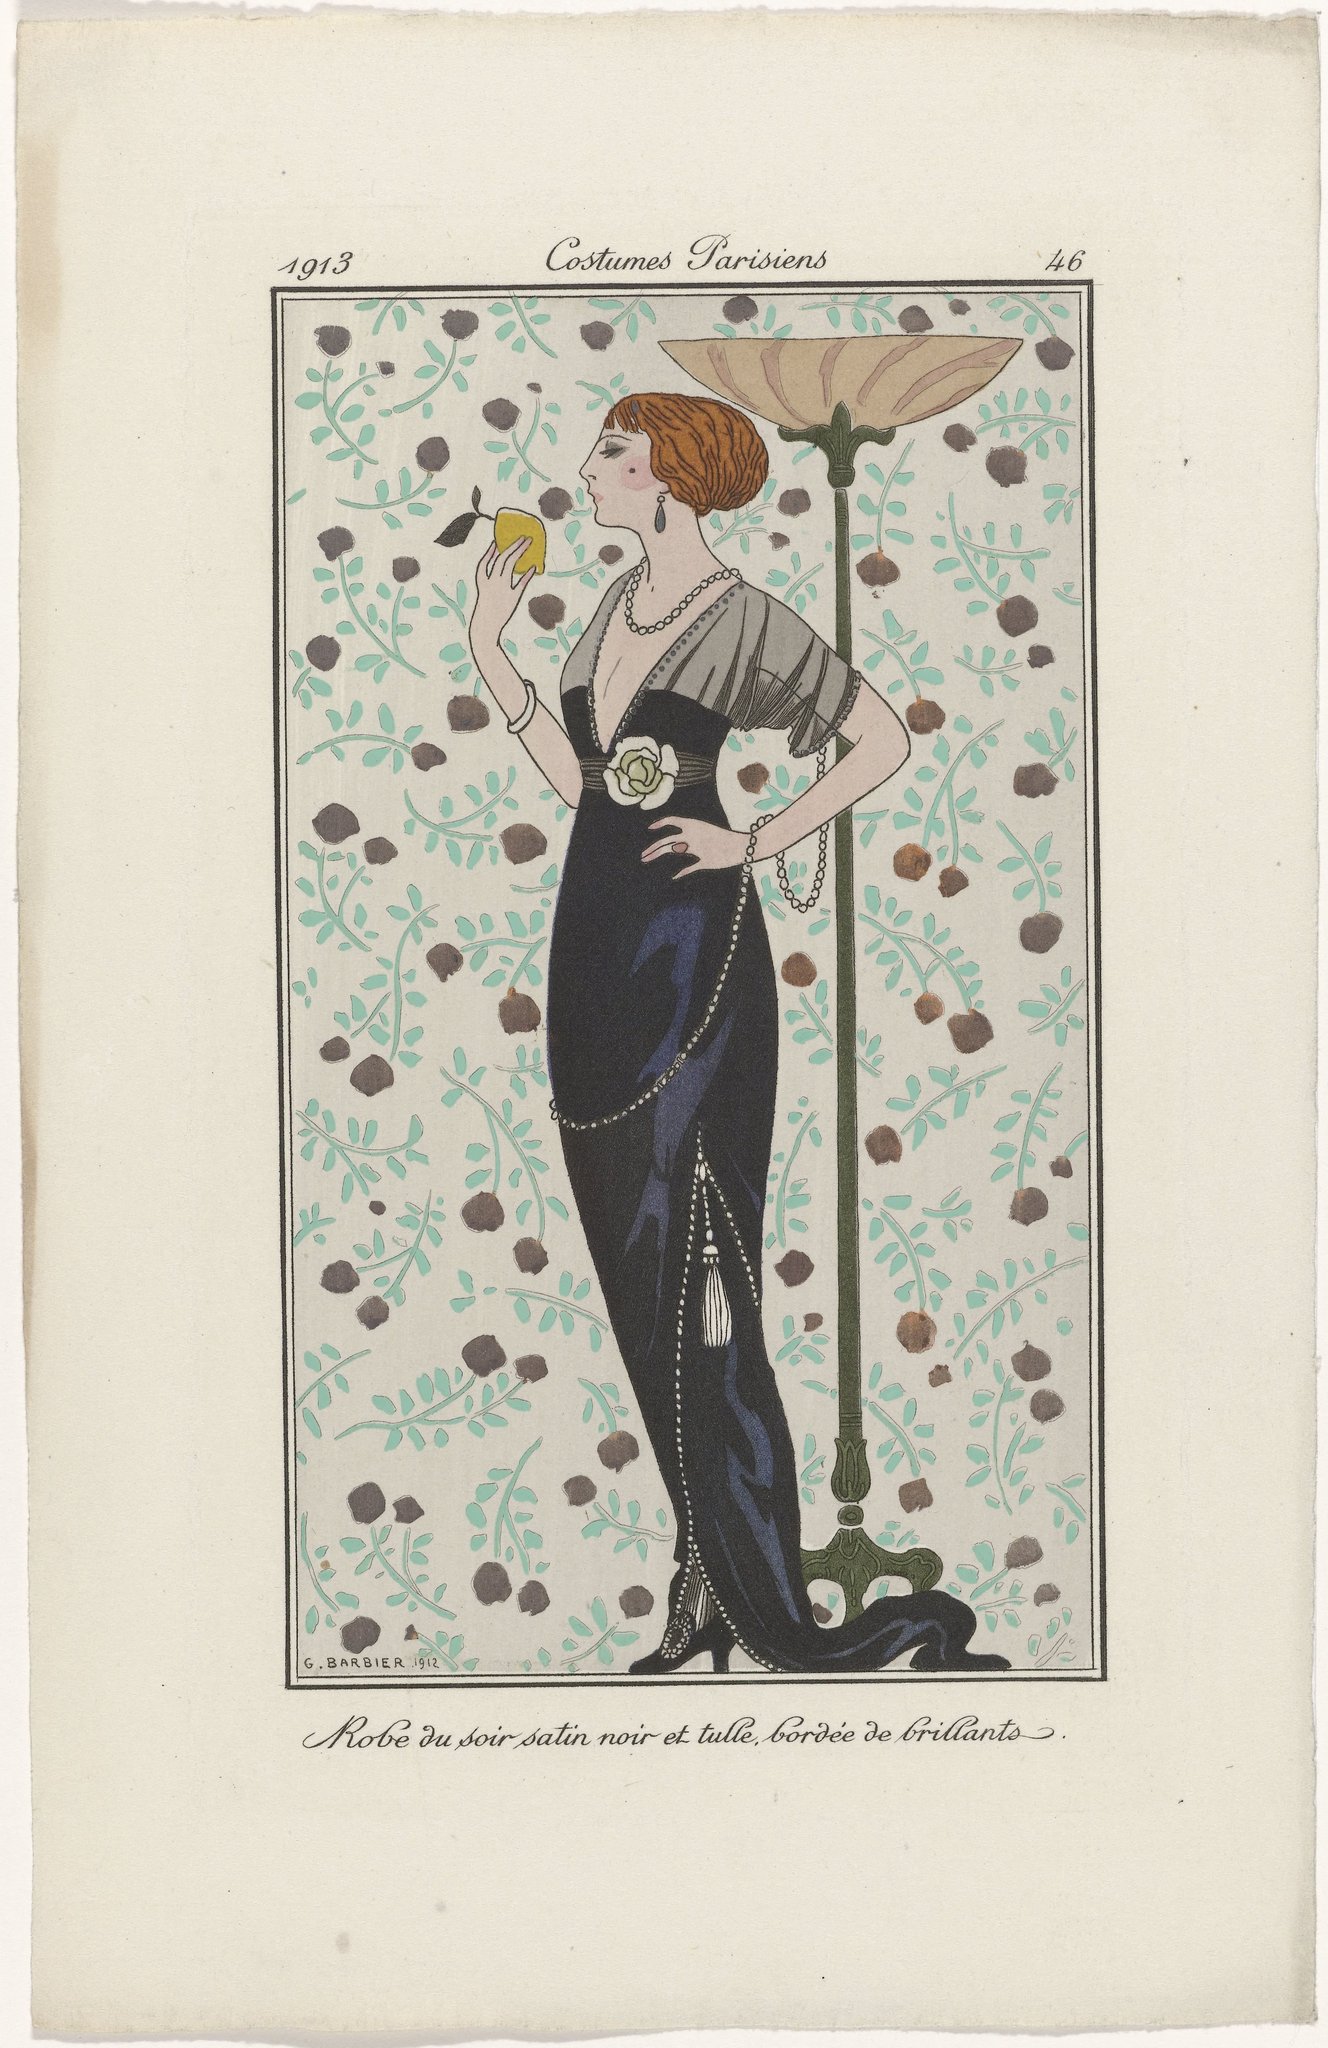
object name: fashion print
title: Journal des Dames et des Modes, Costumes Parisiens, 1913, No. 46 : Robe du soir..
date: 1913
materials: paper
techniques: engraving, hand coloring, pochoir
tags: dress, gown: evening dress (+ women's clothes), border, ribbon, braid (+ other materials used for clothes), fashion plates, lighting; lamps, fruits: lemon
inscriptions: caption: ‘Robe du soir satin noir et tulle, bordée de brillants.’, title: ‘Costumes Parisiens’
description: Vrouw met citroen in de hand, in een avondjurk van zwart satijn en tule, afgezet met briljanten. Achter haar een staande lamp. Prent uit het modetijdschrift Journal des Dames et des Modes (1912-1914).